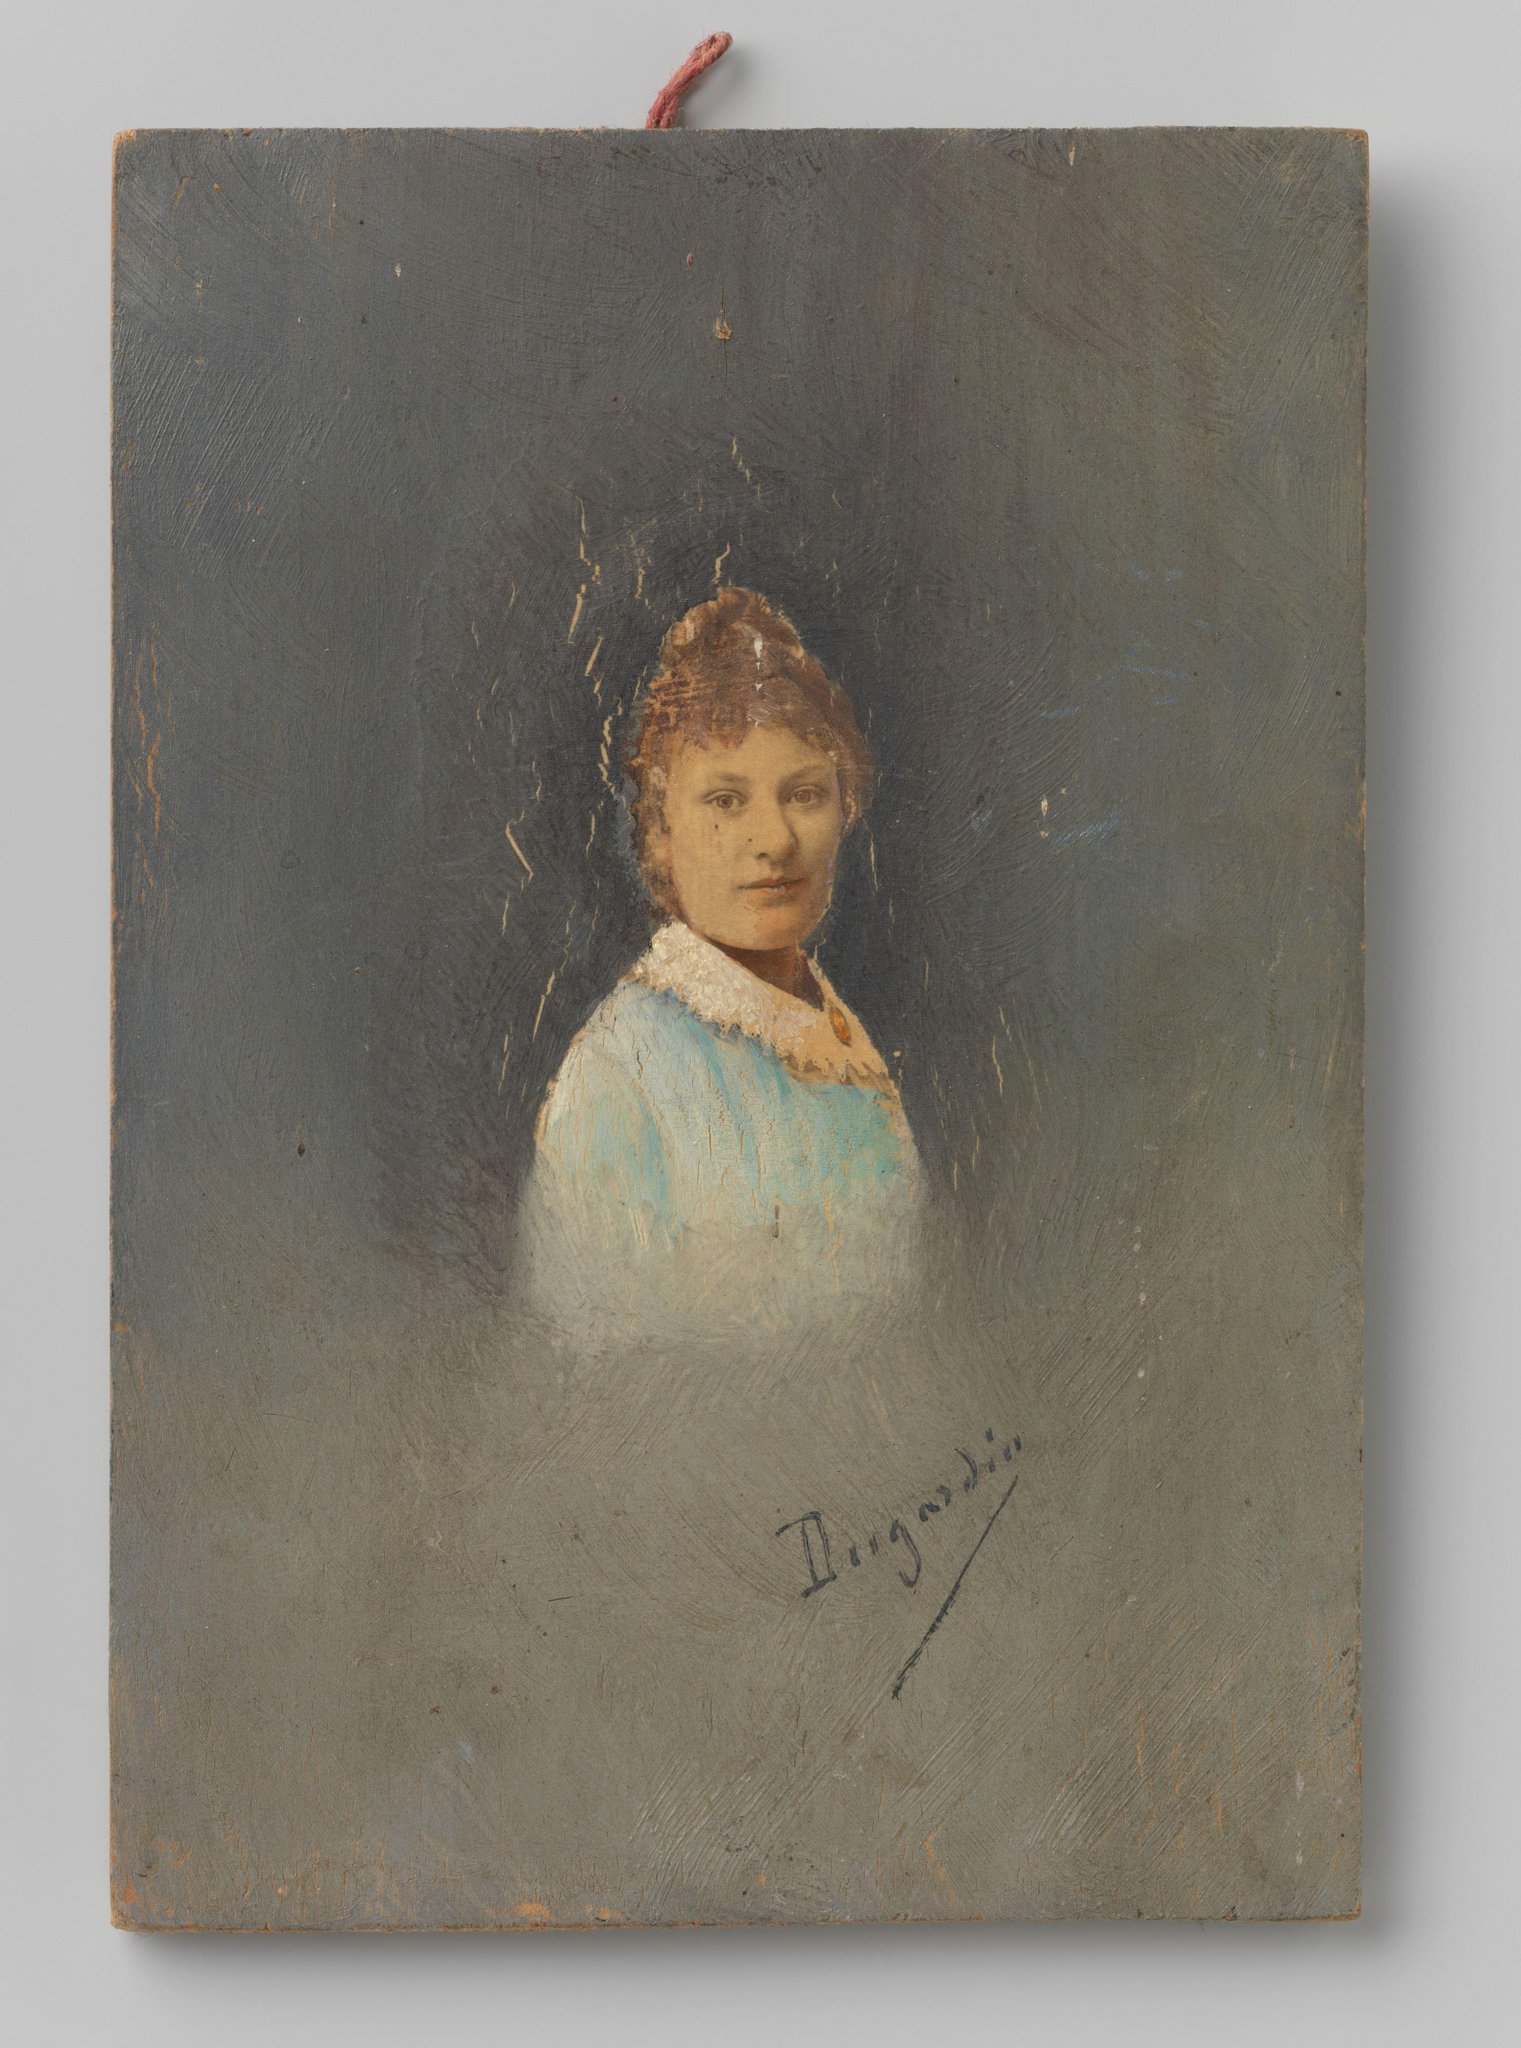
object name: photograph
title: Portret van een onbekende vrouw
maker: Anonymous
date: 1880-1900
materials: metal, paint, paper, fiber, wood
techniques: albumen print, hand coloring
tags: anonymous historical person portrayed - bb - woman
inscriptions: inscription: ‘Luech/ 16073’, inscription: ‘Dugardin[?]’